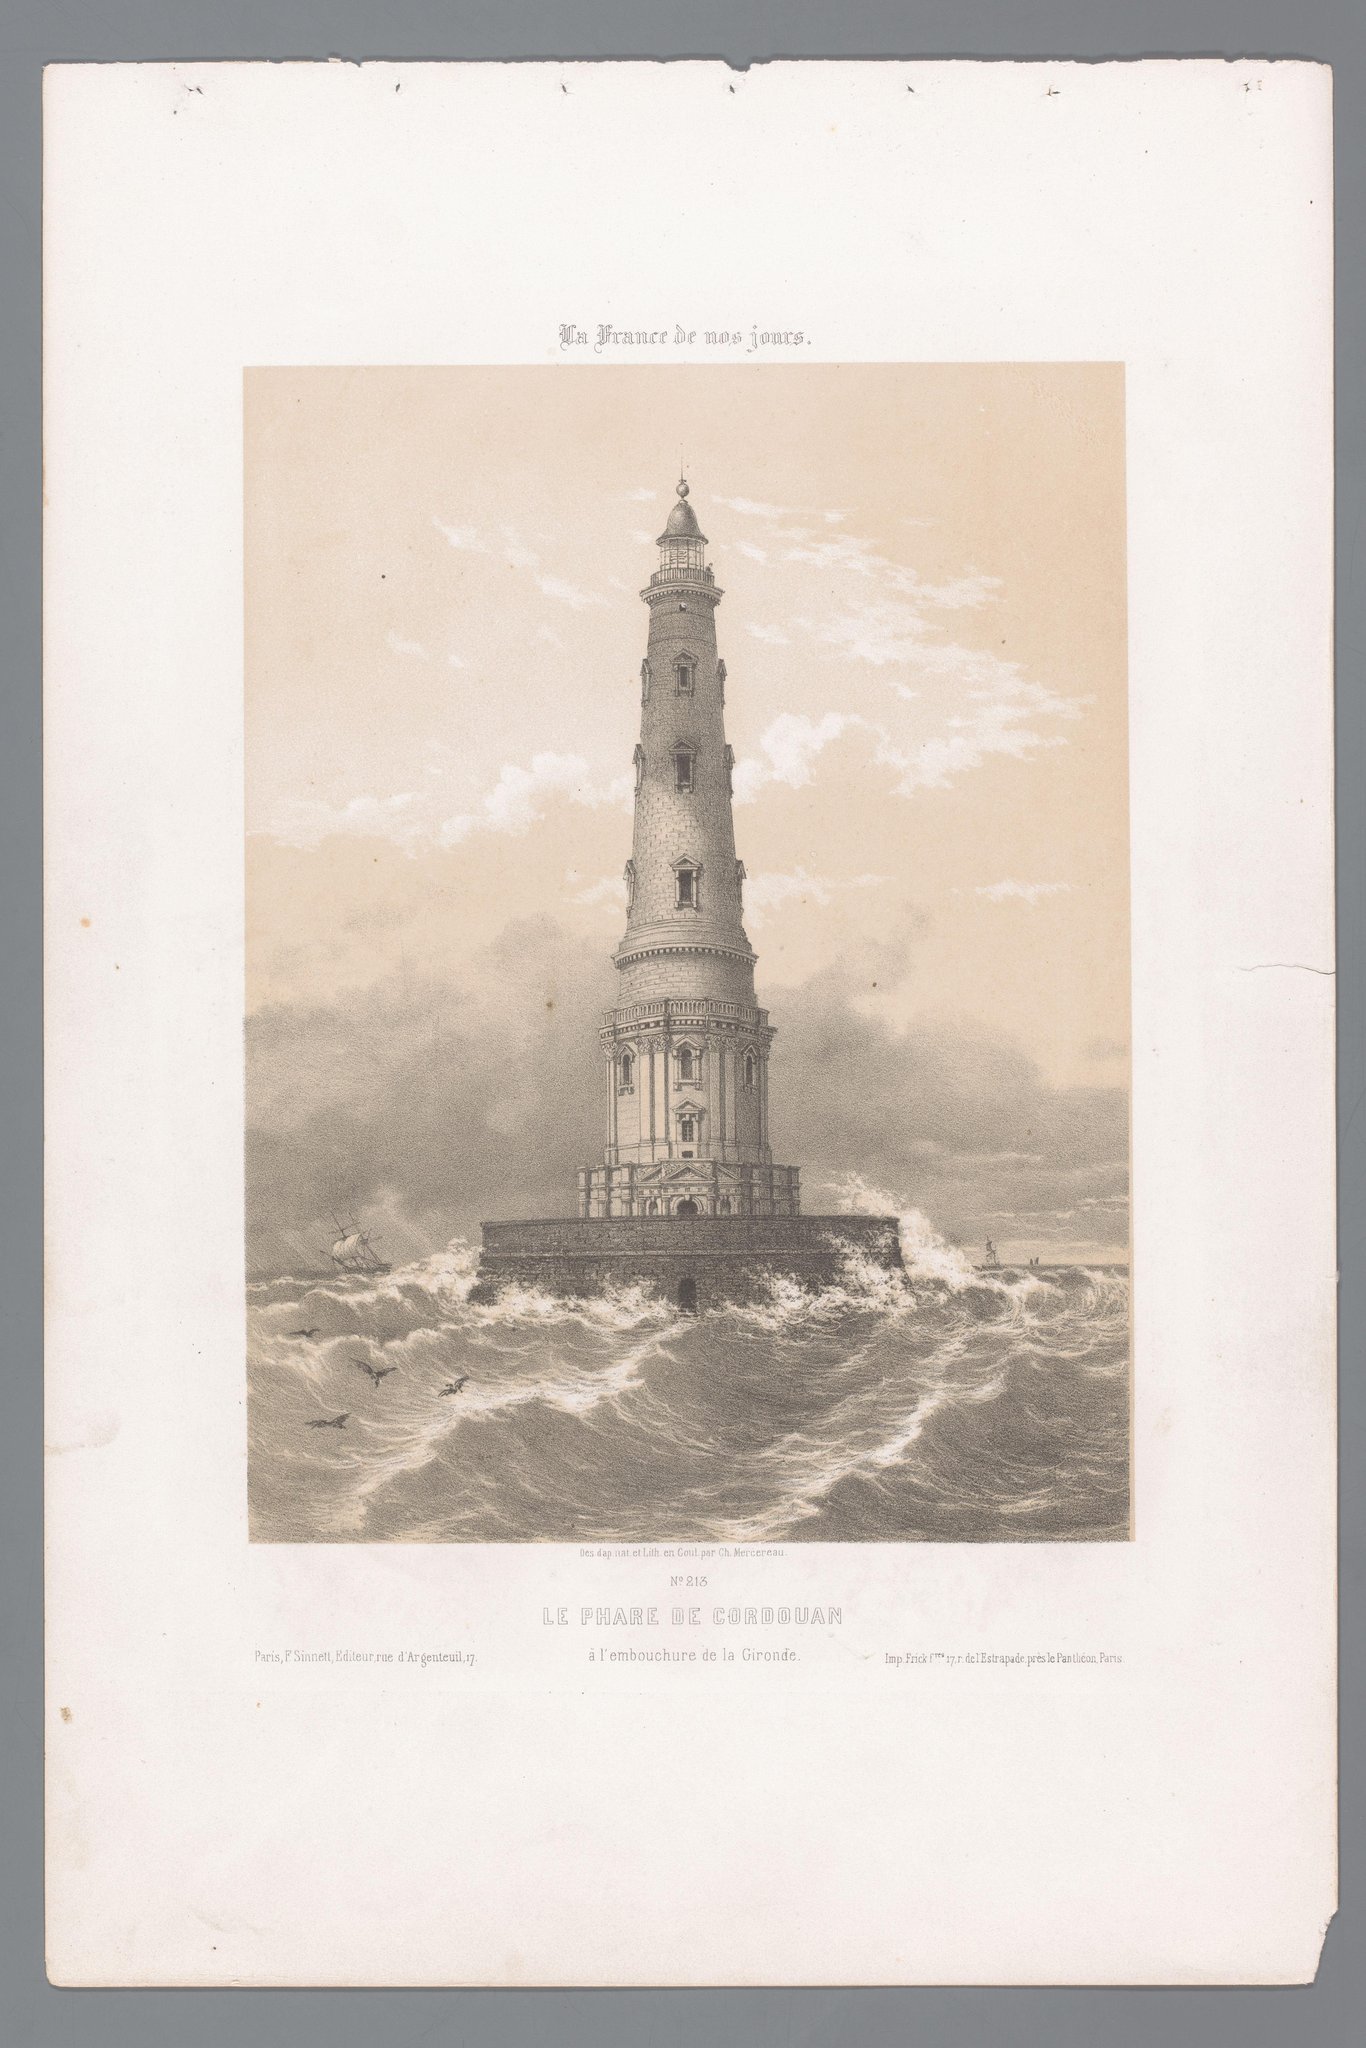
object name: print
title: Gezicht op de vuurtoren van Cordouan aan de monding van de Gironde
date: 1856-1874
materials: paper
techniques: tone lithography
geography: paris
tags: lighthouse, lightship, city-view, and landscape with man-made constructions, ships (in general) - cc - more than one ship, sea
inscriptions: collector's mark: Lugt 2228